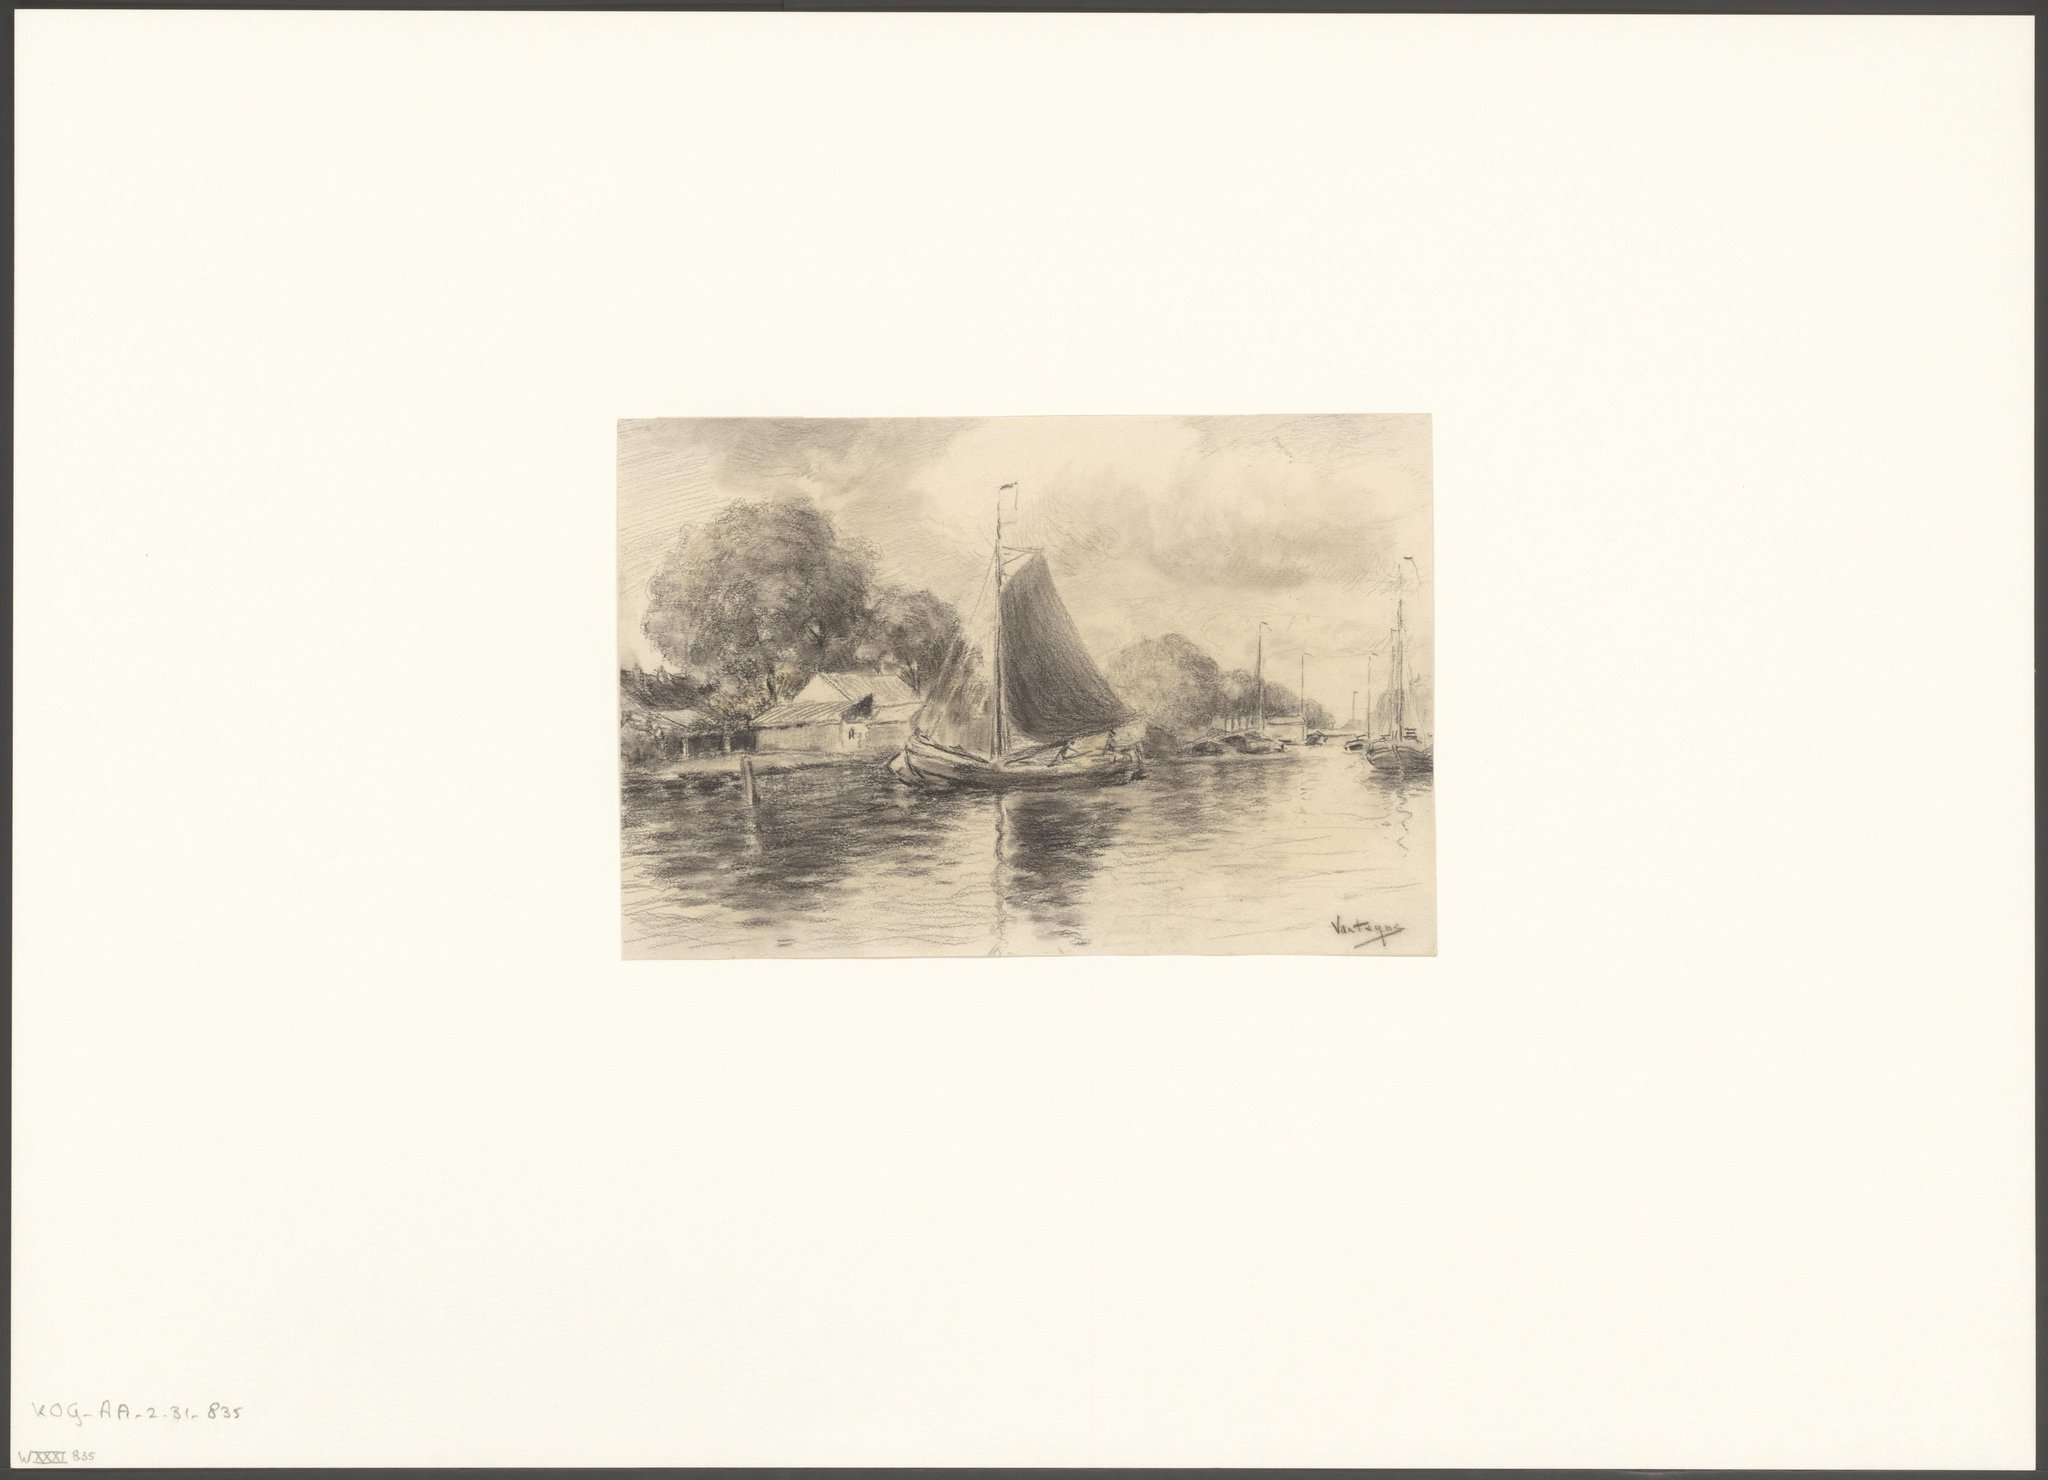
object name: drawing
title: Gezicht op de Schinkel nabij Huis Te Vraag, gezien vanaf het rangeerterrein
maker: anthonie van teijn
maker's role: draughtsman, painter, print maker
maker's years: 1863-1943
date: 1908-1927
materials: chalk, paper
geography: amsterdam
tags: city-view in general; 'veduta', canal, boat propelled by man or animal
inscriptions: collector's mark: Lugt 800a, inscription: ‘Schinkel’, signature: ‘VanTeyne’, inscription: ‘De Schinkel nabij (...) Aug 1927 / vanEck’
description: Tekening binnen de Atlas Van Eck ingedeeld op wijknummer 31.